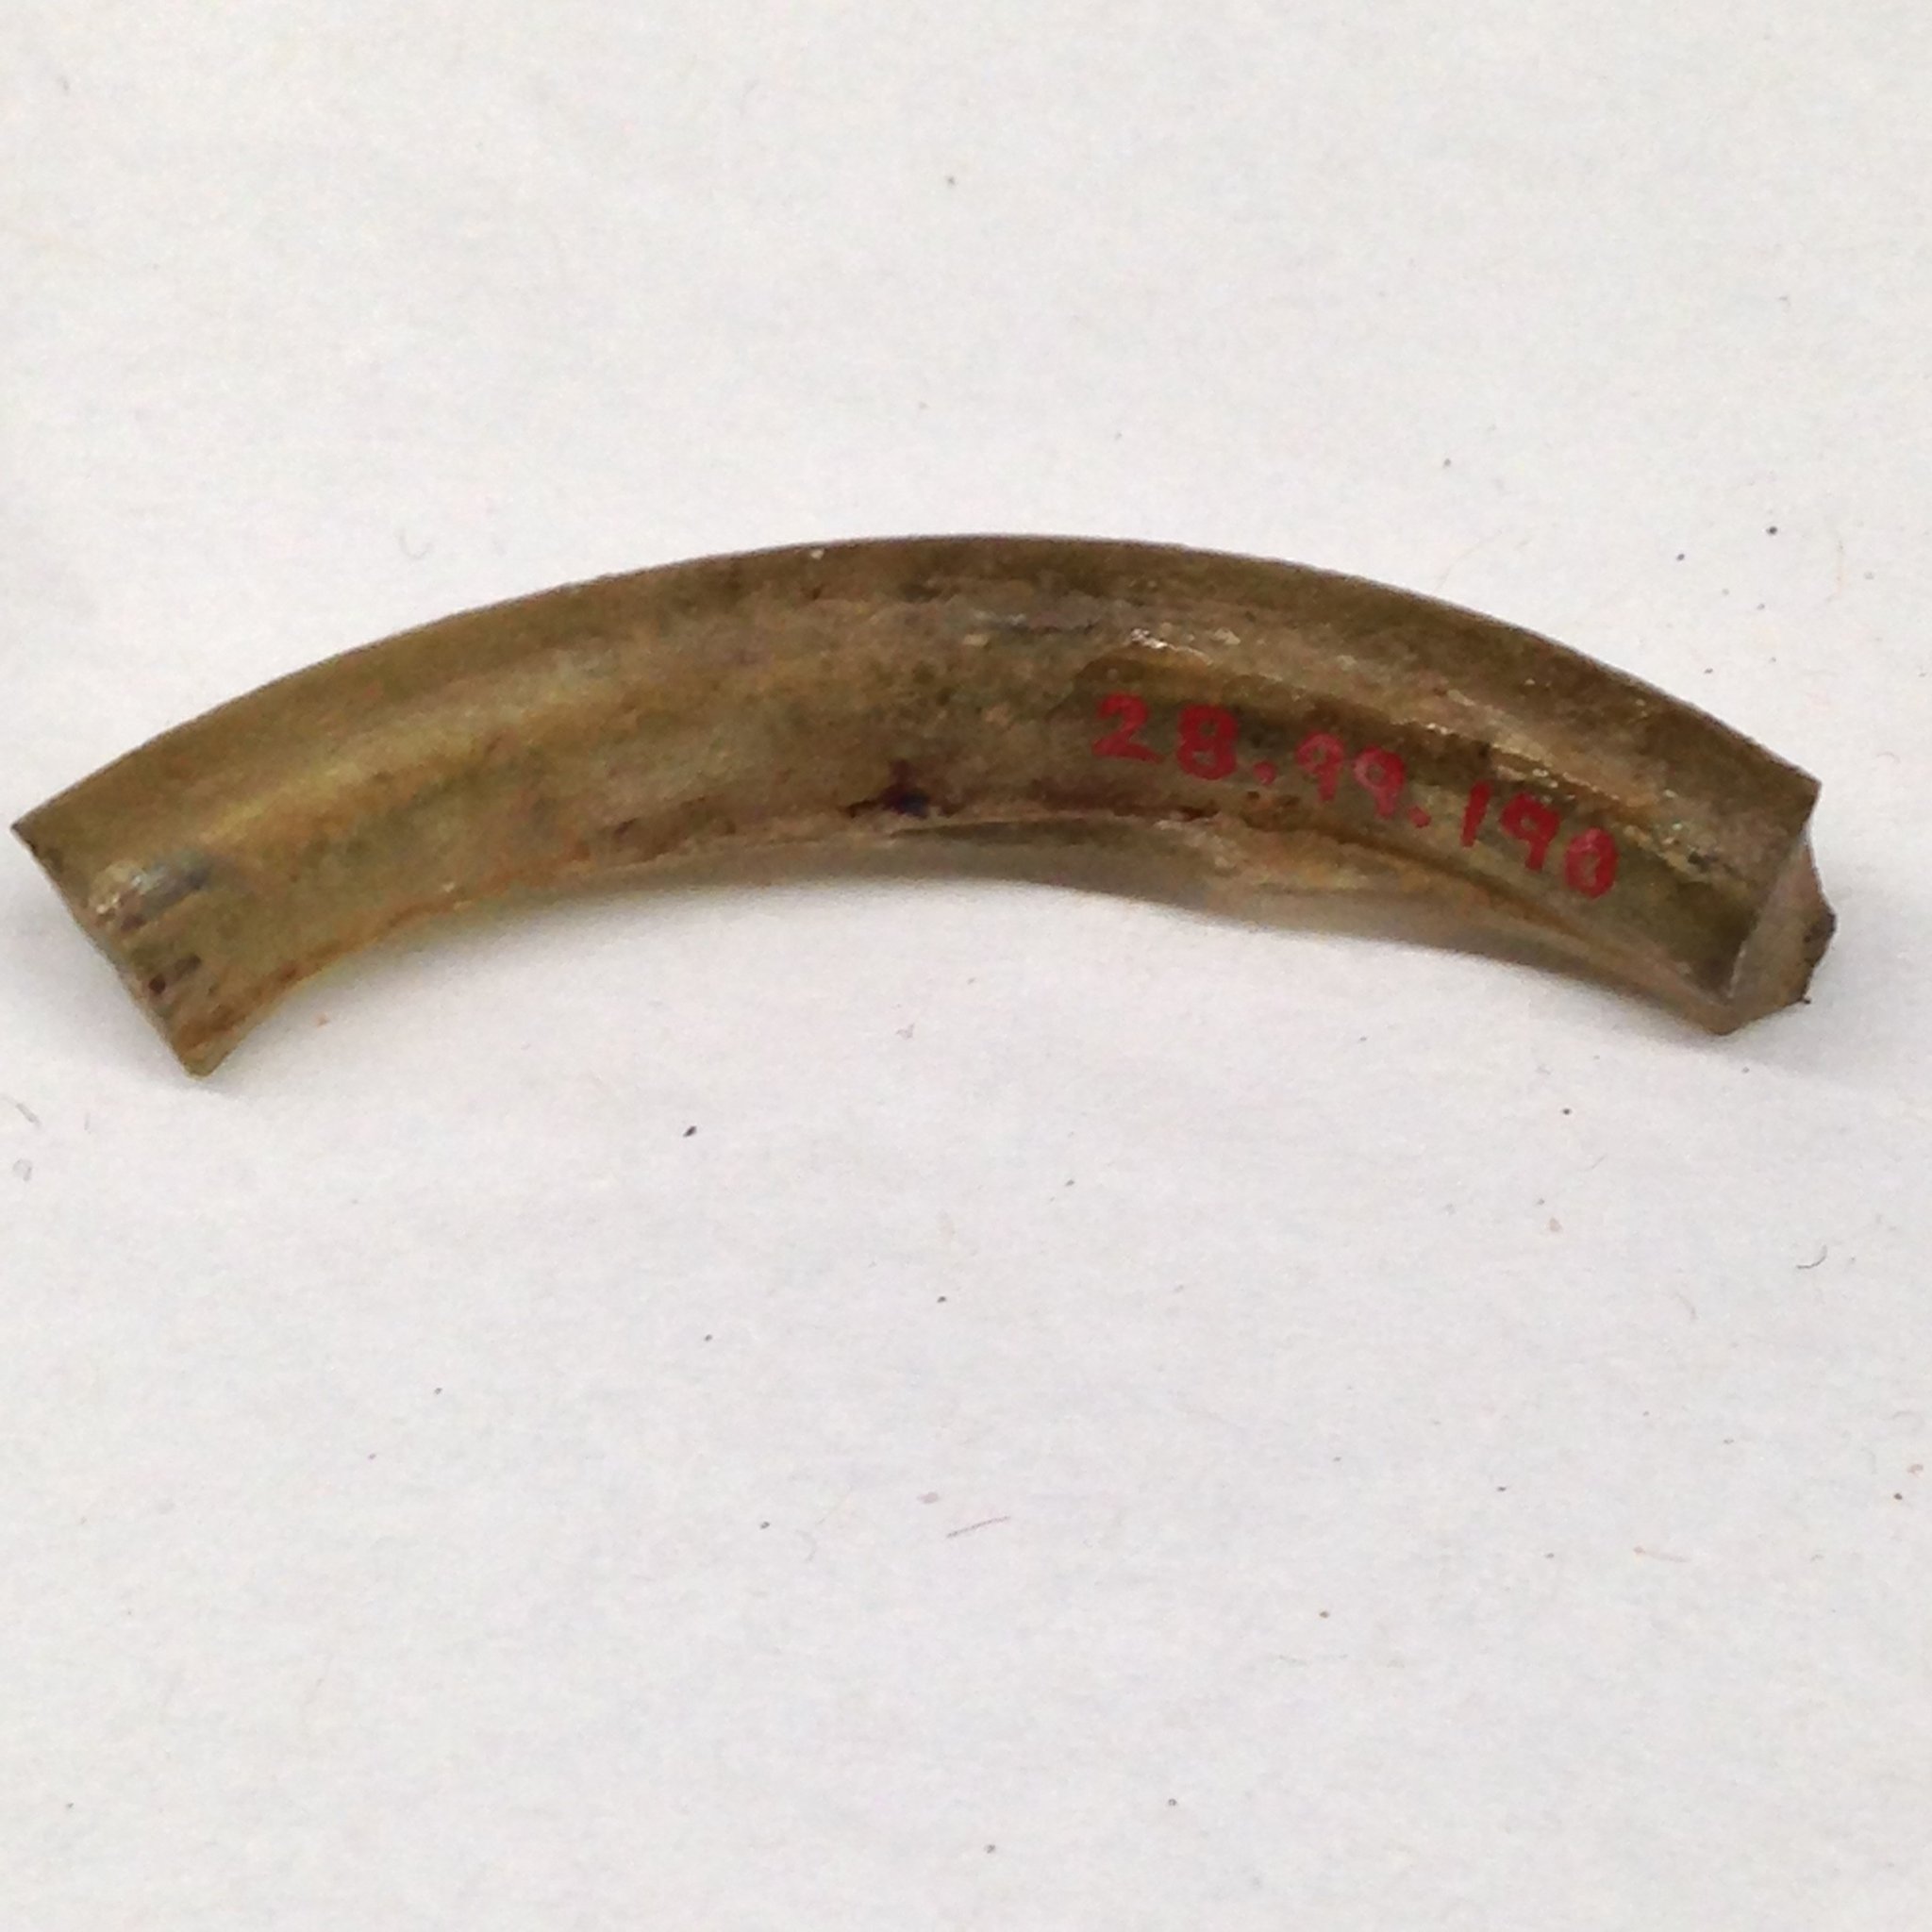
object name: fragment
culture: european or middle eastern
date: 1150-1250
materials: ceramic, glass